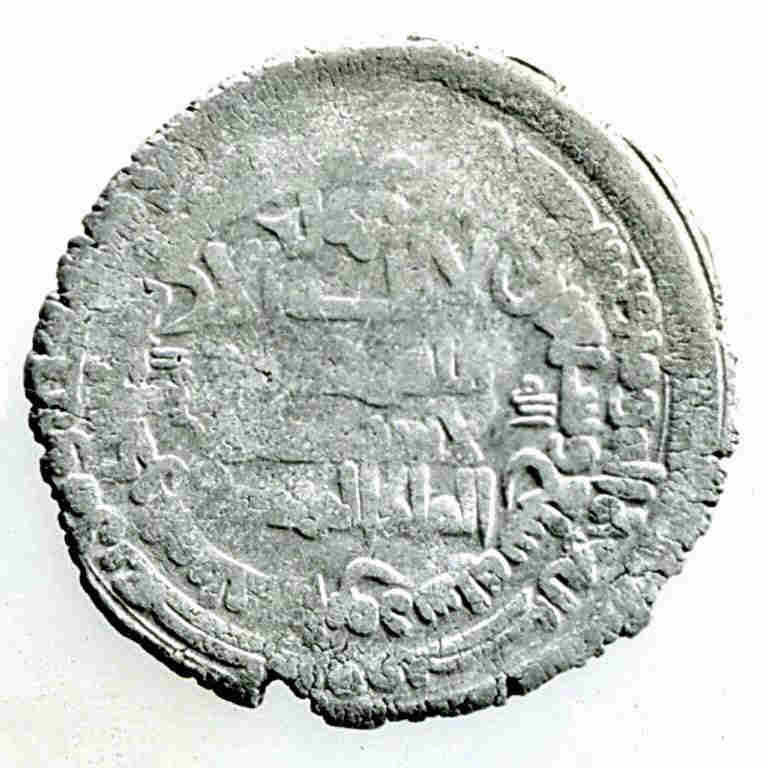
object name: coin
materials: silver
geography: iran